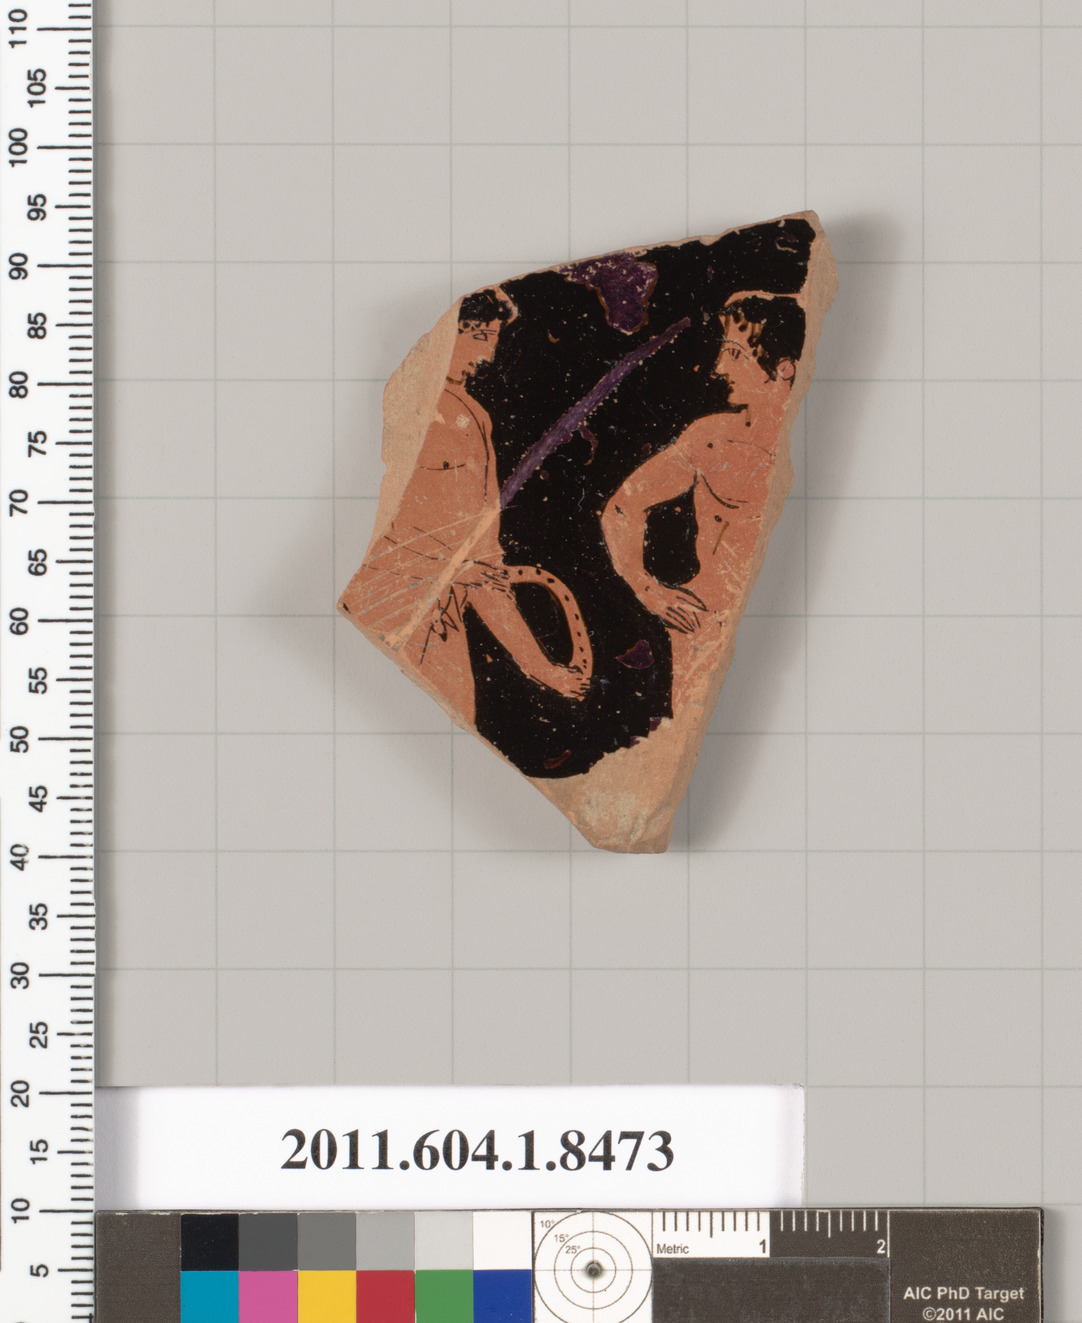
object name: kylix fragment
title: Terracotta fragment of a stemless kylix (drinking cup)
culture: greek, attic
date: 460-450 BCE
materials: terracotta